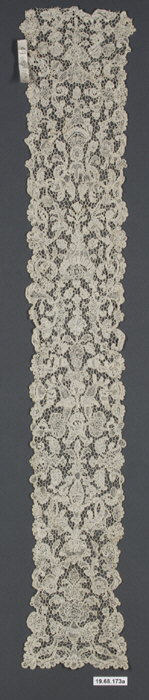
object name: lappet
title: Lappet (one of a pair)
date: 1701-1800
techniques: lace